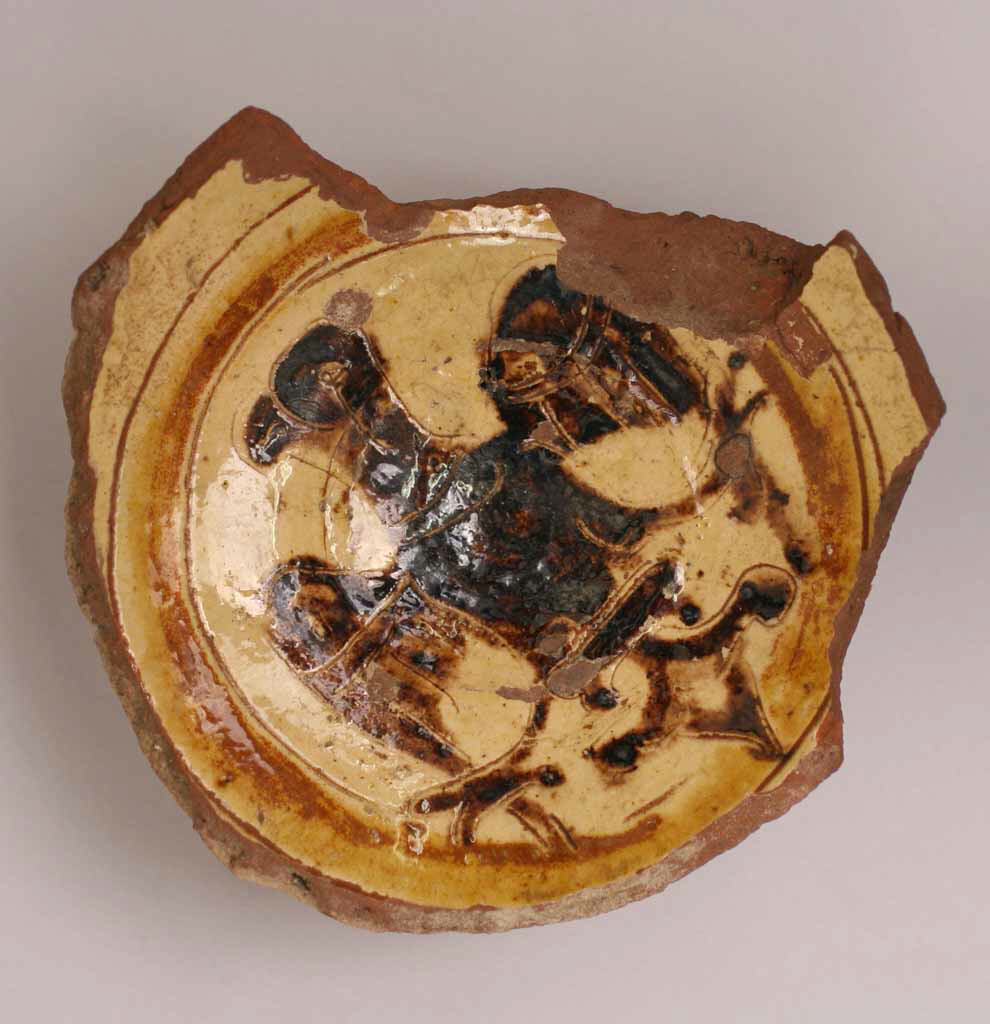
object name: fragment of a bowl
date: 1301-1400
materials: glaze, stonepaste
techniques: painting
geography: egypt